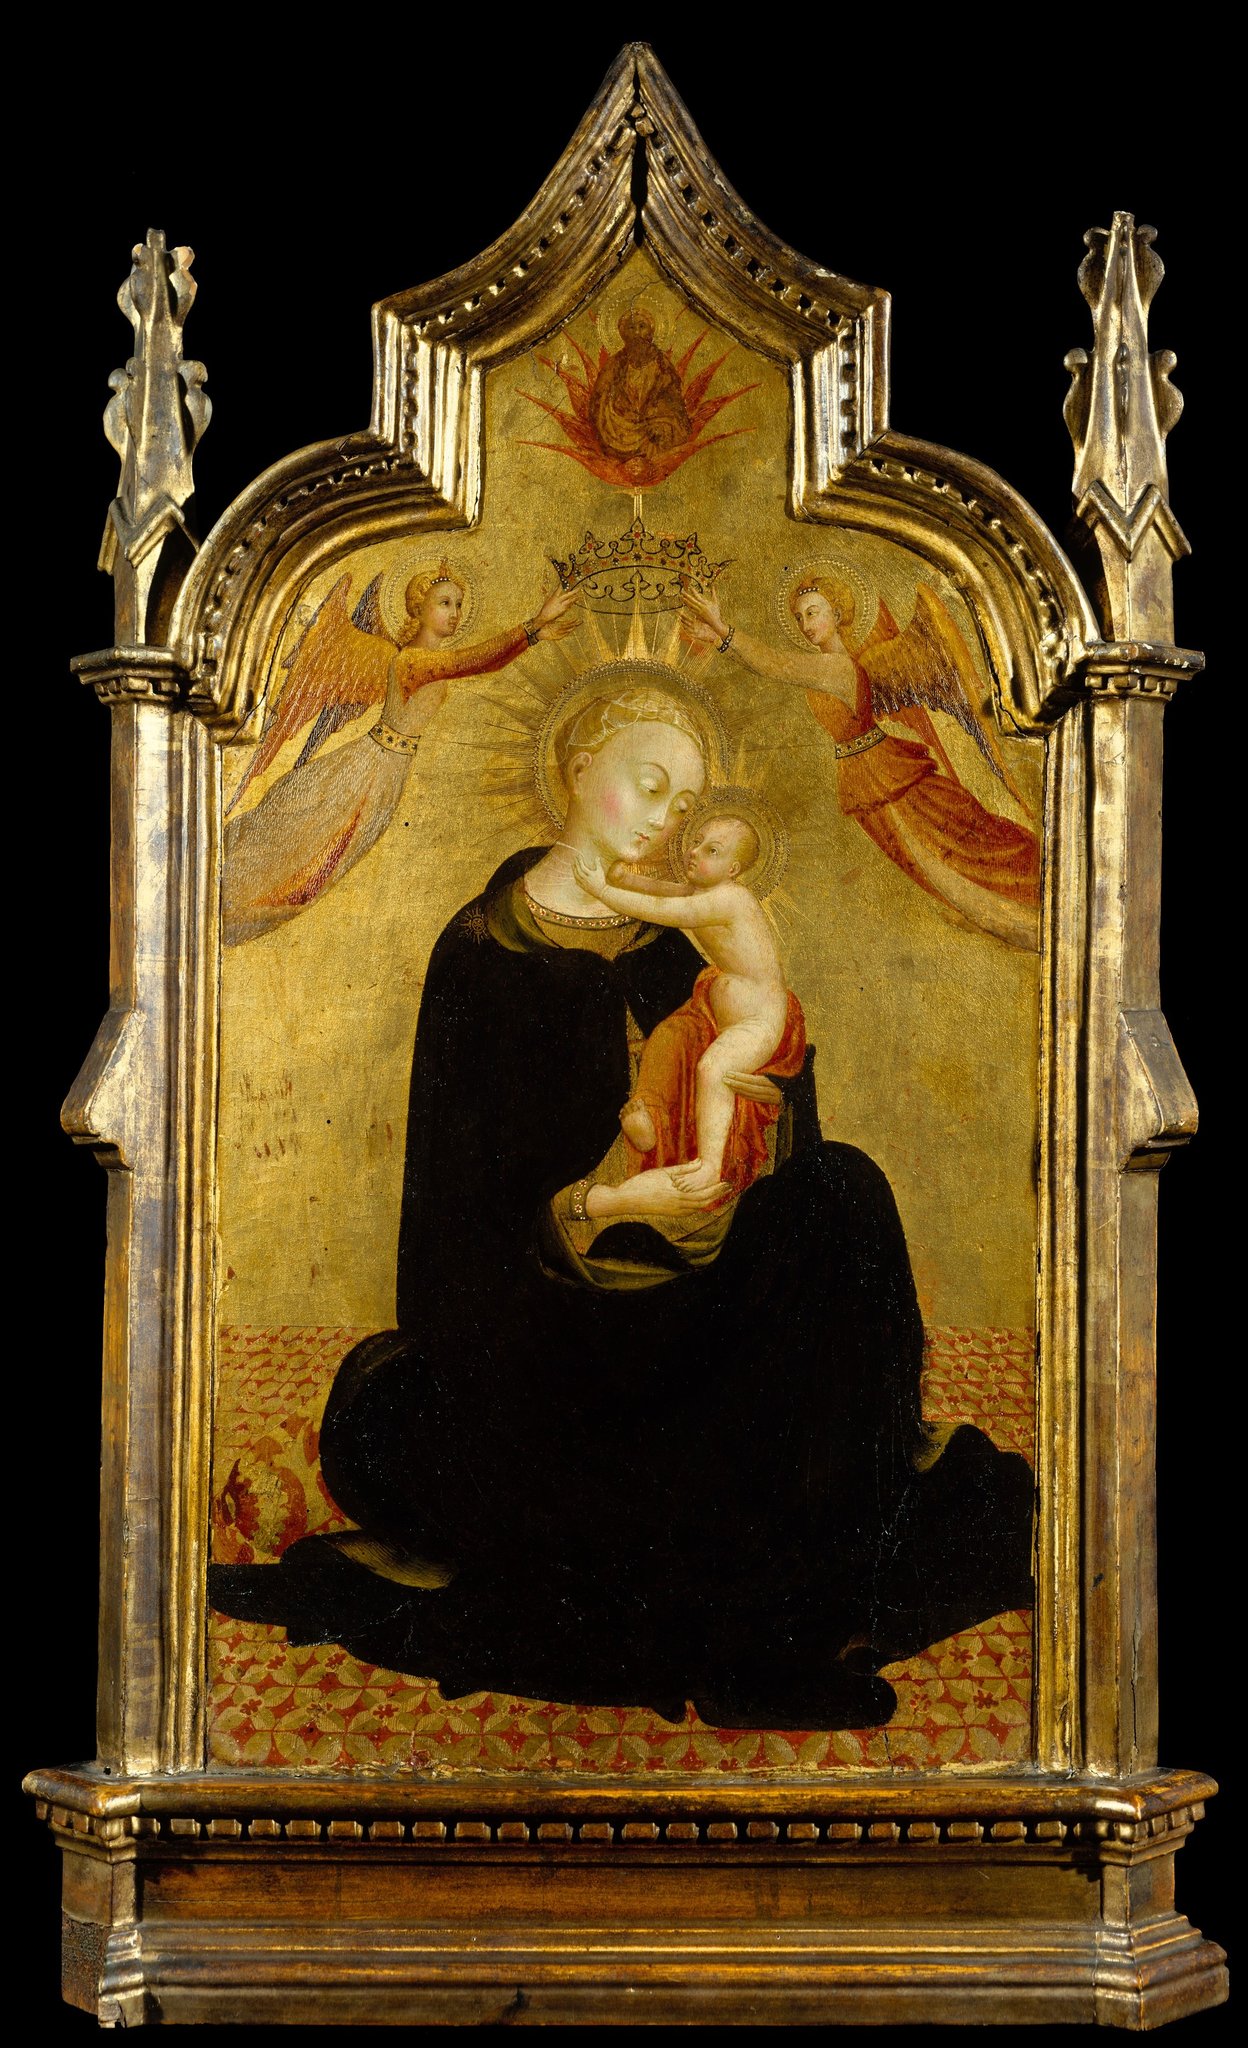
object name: painting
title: Madonna and Child with Angels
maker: sassetta (stefano di giovanni)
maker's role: artist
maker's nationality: italian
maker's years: 1400-1450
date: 1445-1450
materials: gold leaf, paint, wood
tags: angels,madonna and child